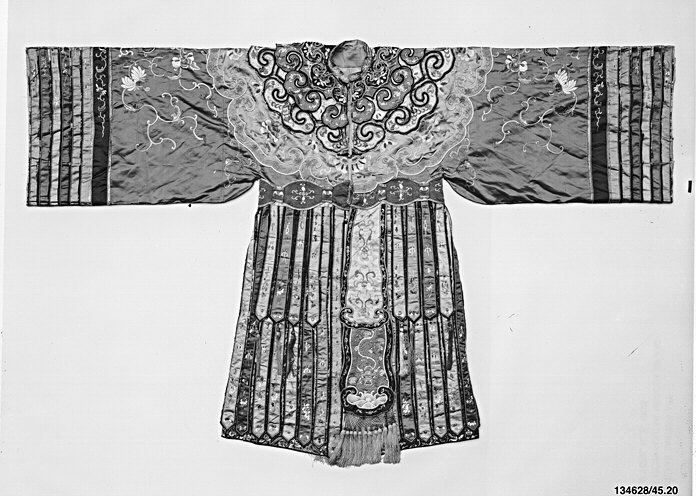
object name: robe, dancer's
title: Dancer's Robe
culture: chinese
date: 1801-1900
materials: silk